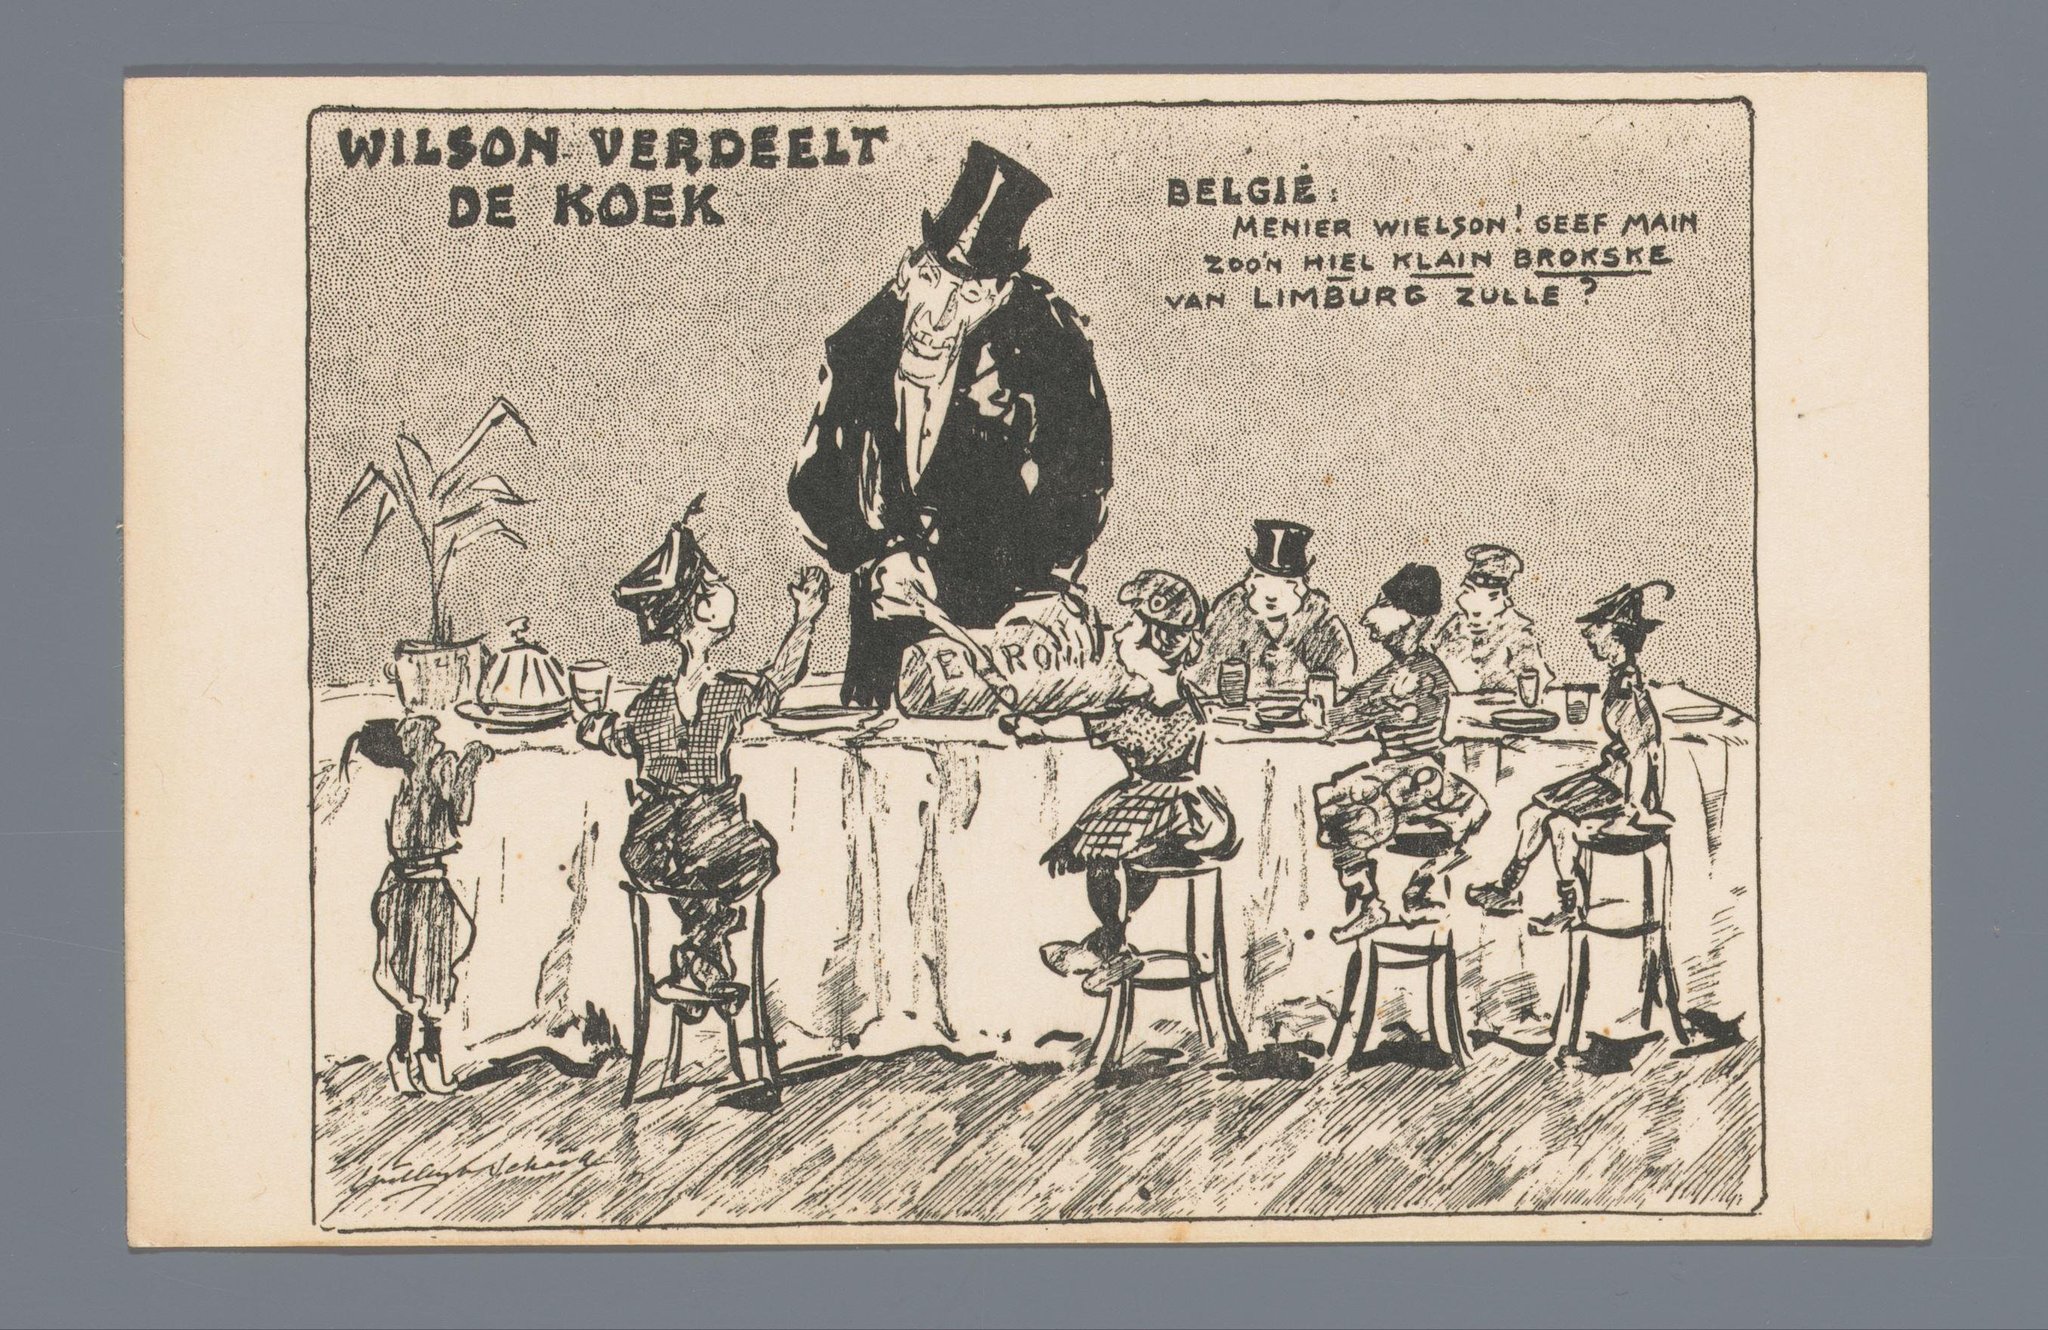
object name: postcard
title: Wilson verdeelt de koek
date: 1919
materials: paper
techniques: printing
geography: bussum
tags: staunton, washington d.c., president, staatsman, thomas woodrow wilson, vrede van versailles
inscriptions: : ‘EURO...’, : ‘BELGIË: / MENIER WIELSON! GEEF MAIN / ZOO'N HIEL KLAIN BROKSKE / VAN LIMBURG ZULLE ?’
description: Centraal: rechthoekige tafel waarachter grote man (Wilson) in zwarte jas en met hoge hoed op, snijdend aan koek waarop opschrift. Verder 6 personen, 5 mannen en een vrouw met verschillende hoofddeksels op. Geheel in zwart en wit.